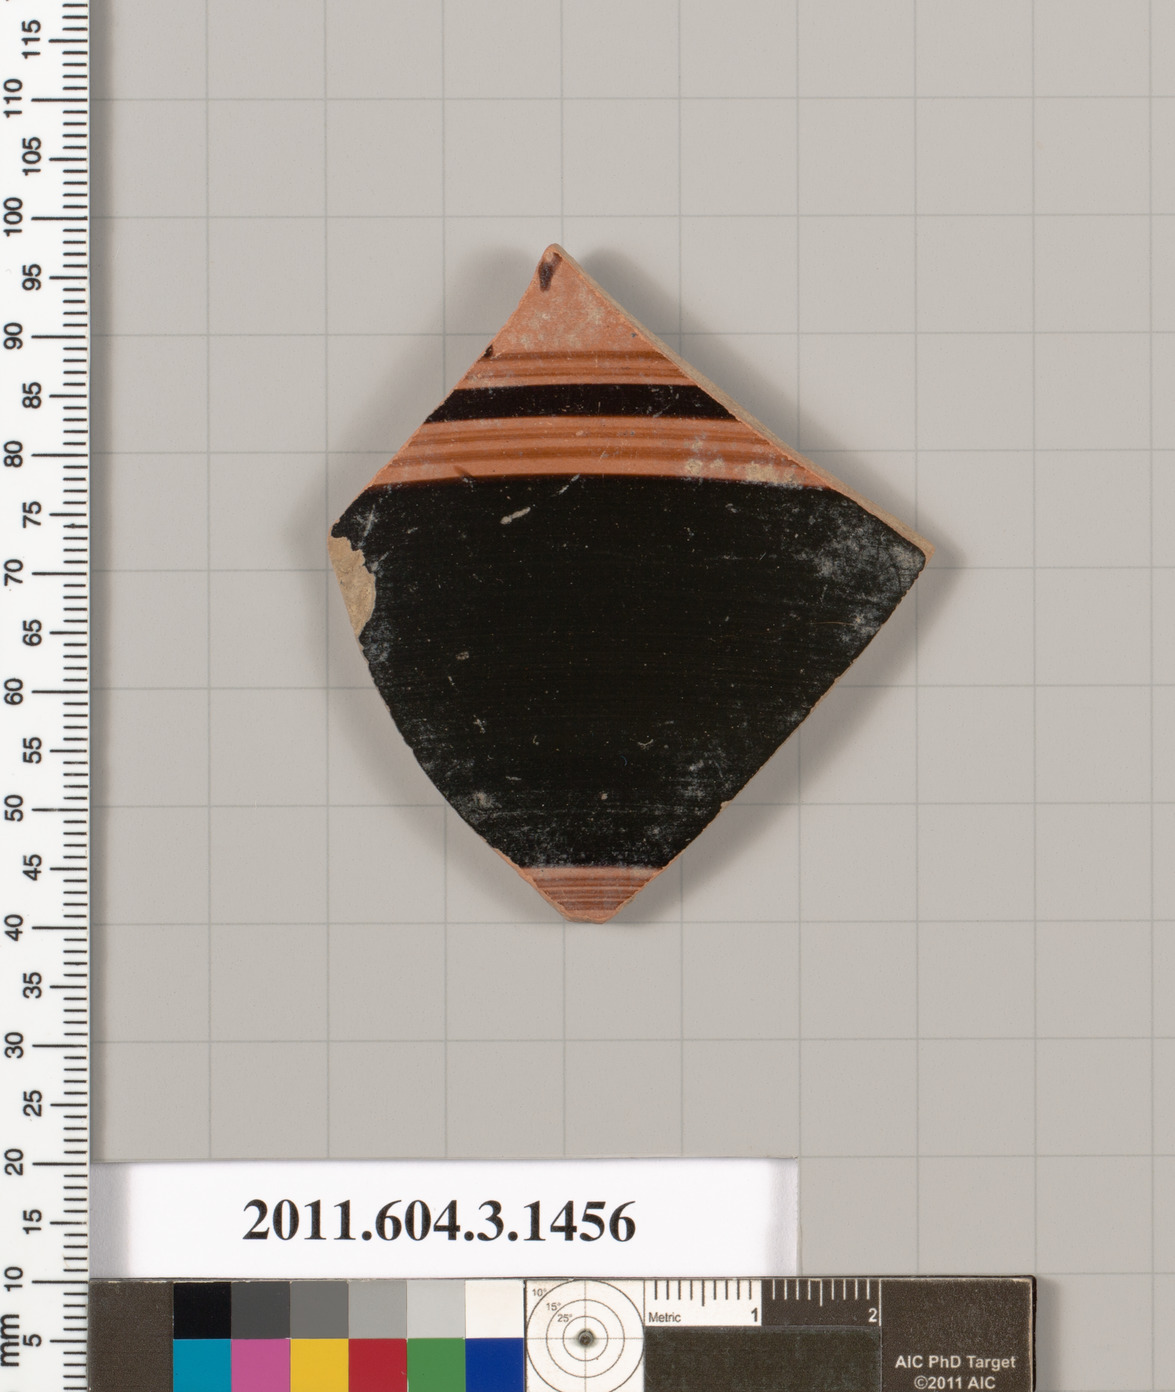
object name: skyphos fragment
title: Terracotta fragment of a skyphos (deep drinking cup)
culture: greek, attic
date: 534-468 BCE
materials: terracotta